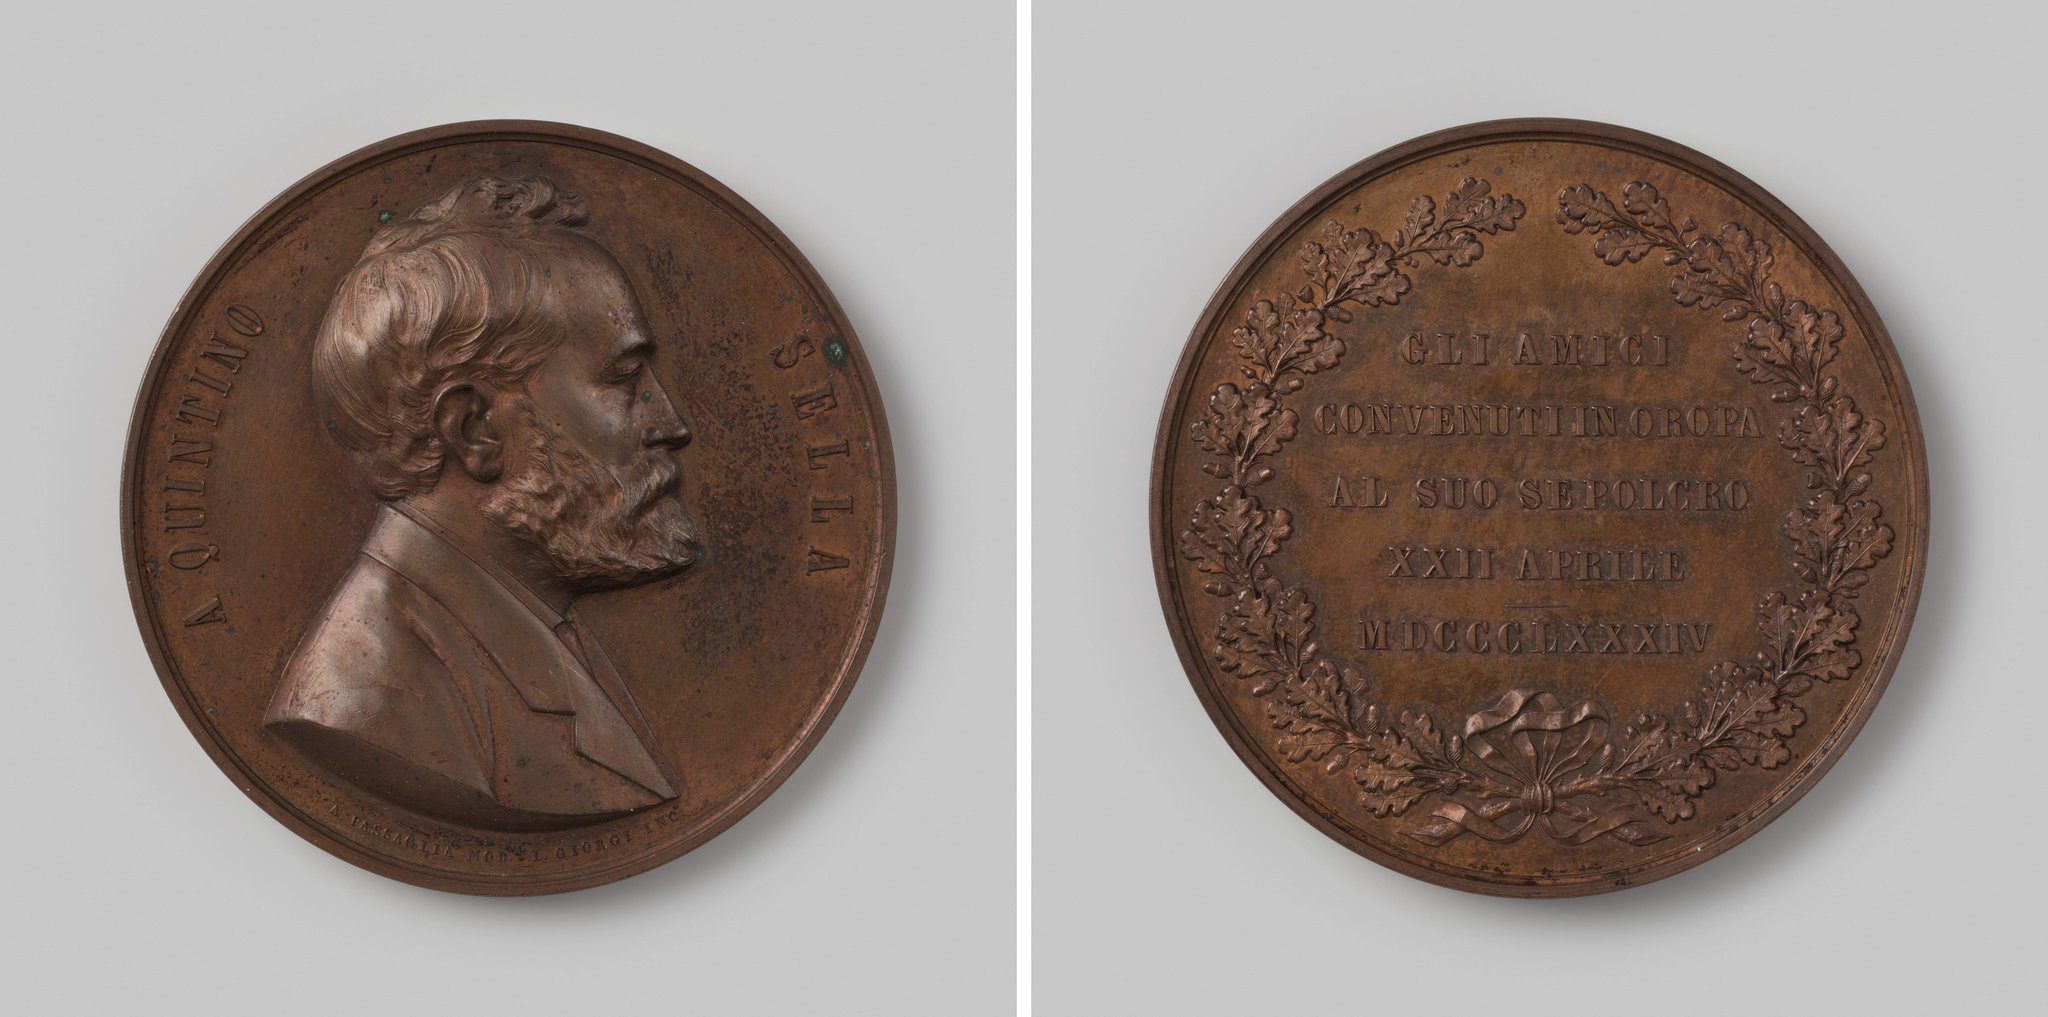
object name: history medal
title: Quintino Selba 1884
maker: georgi. l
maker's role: die cutter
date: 1884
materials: copper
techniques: striking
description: Bronzen penning, op de voorzijde het borstbeeld van Selba naar rechts met omschrift, op de keerzijdevijf regels tekst tussen samengestrikte eikentakken.